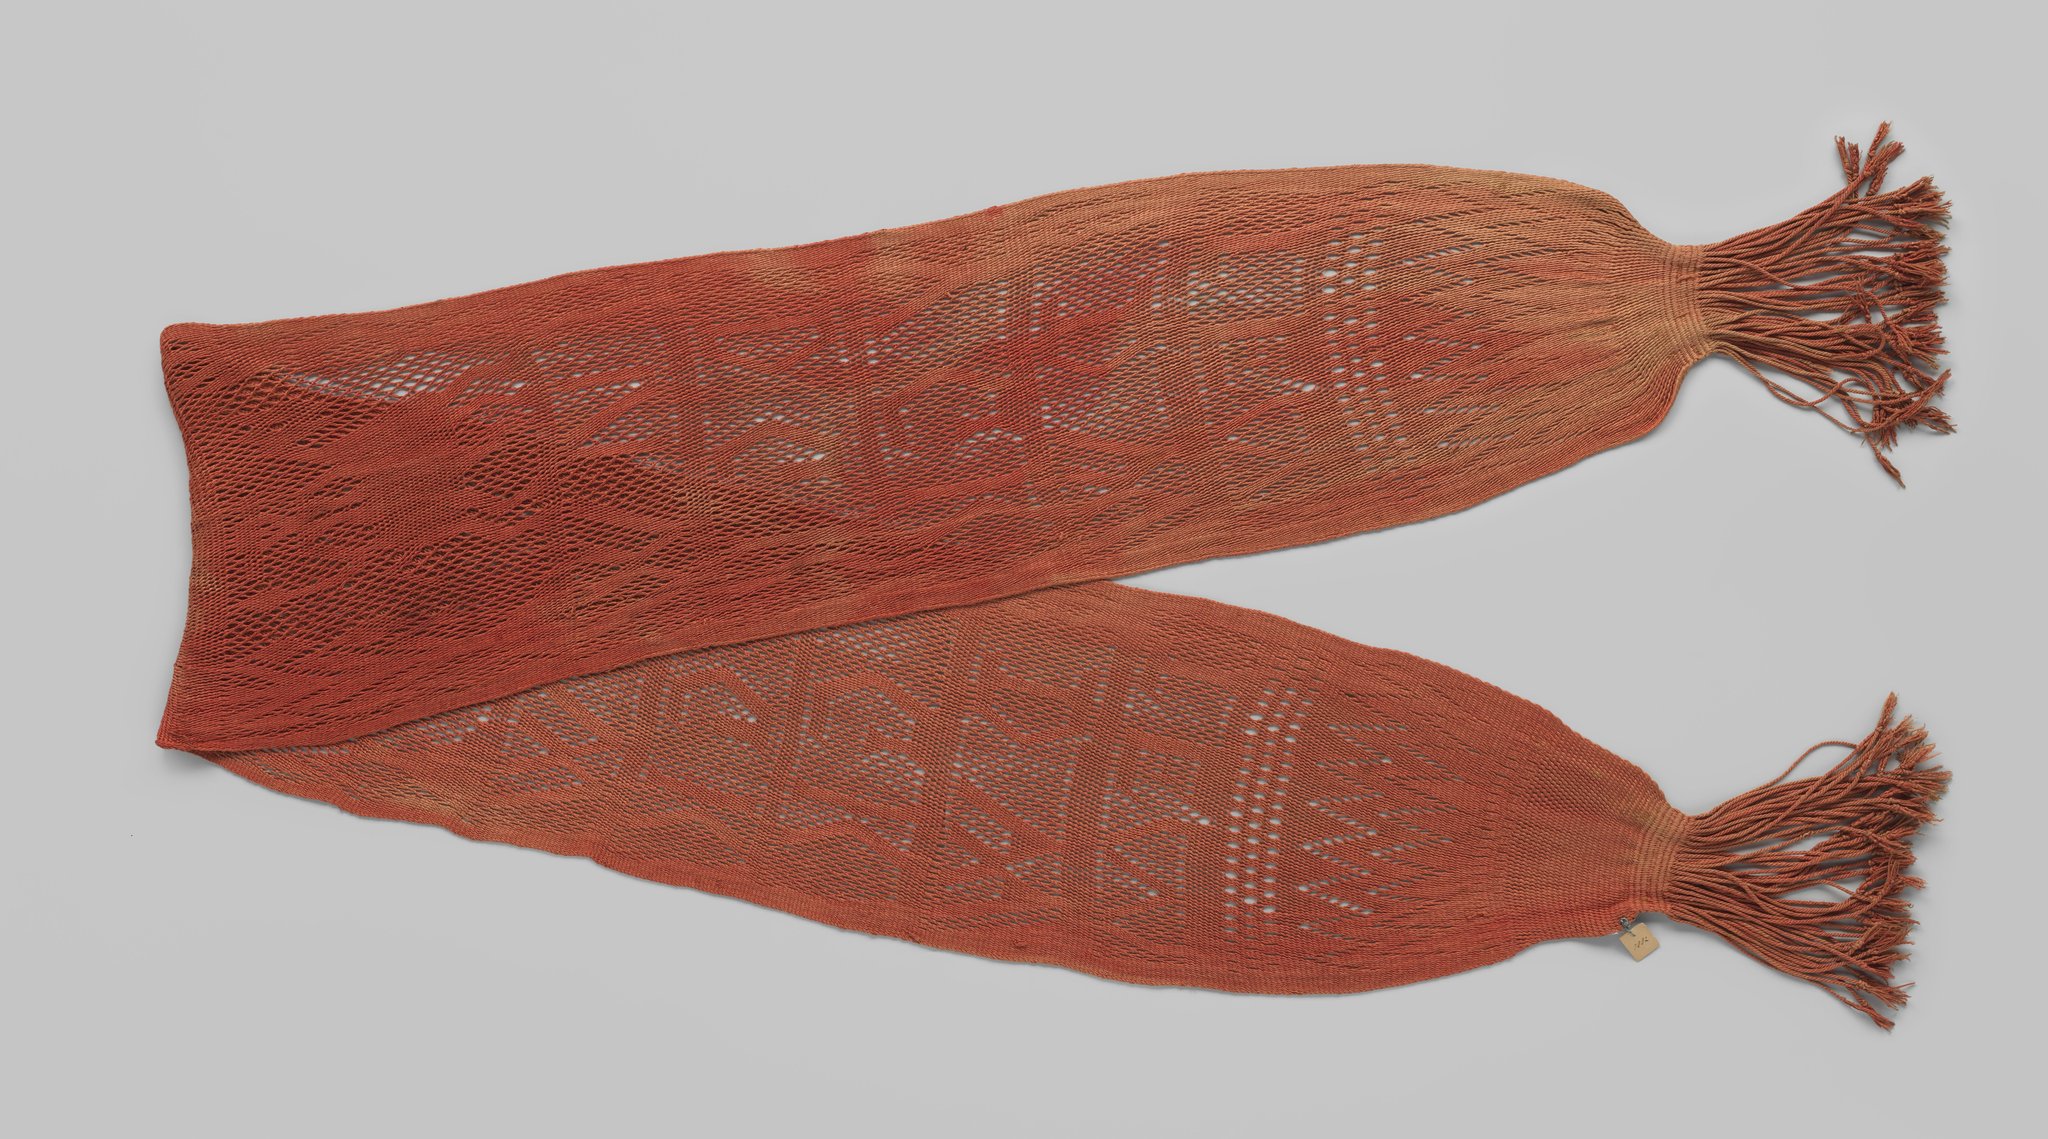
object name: sash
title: Langwerpige rode zijden sjerp in franje van Egyptisch vlechtwerk eindigend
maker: Anonymous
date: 1600-1699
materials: silk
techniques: sprang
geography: western europe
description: Rode zijden sjerp in franje van Egyptisch vlechtwerk eindigend.